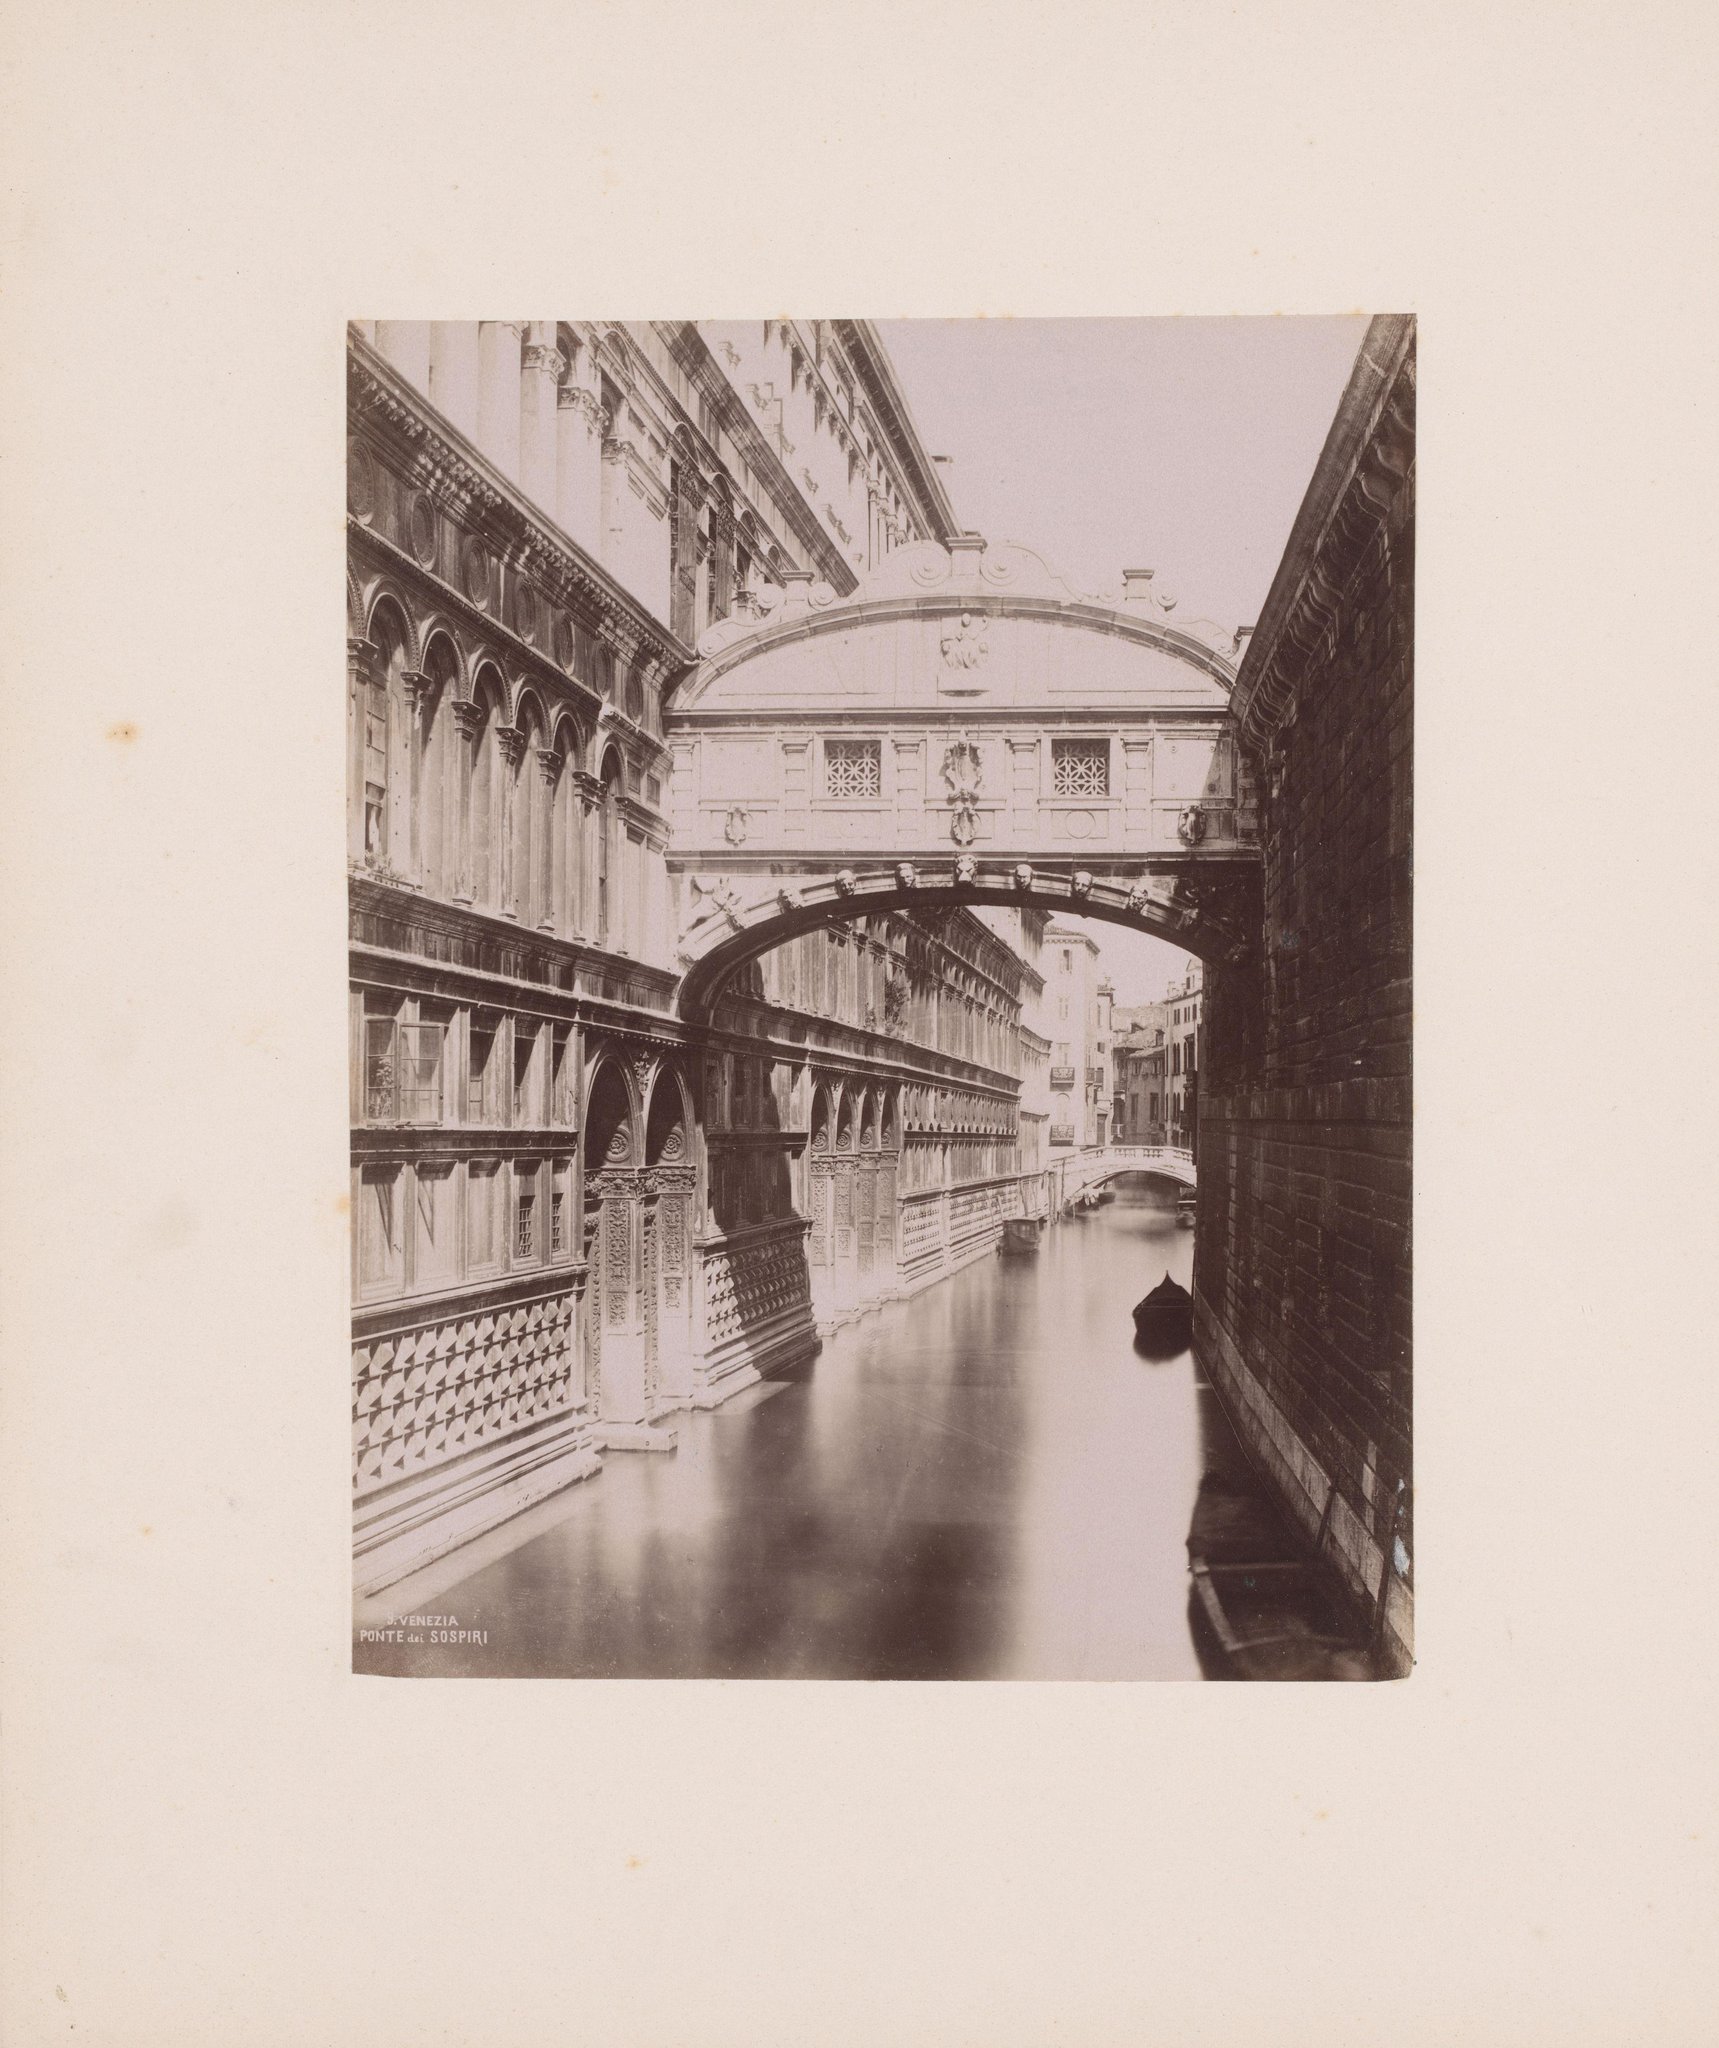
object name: photograph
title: Ponte dei sospiri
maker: Anonymous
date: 1851-1900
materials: cardboard, paper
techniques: albumen print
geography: venice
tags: canals, waters (in city), bridge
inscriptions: number: ‘9.’